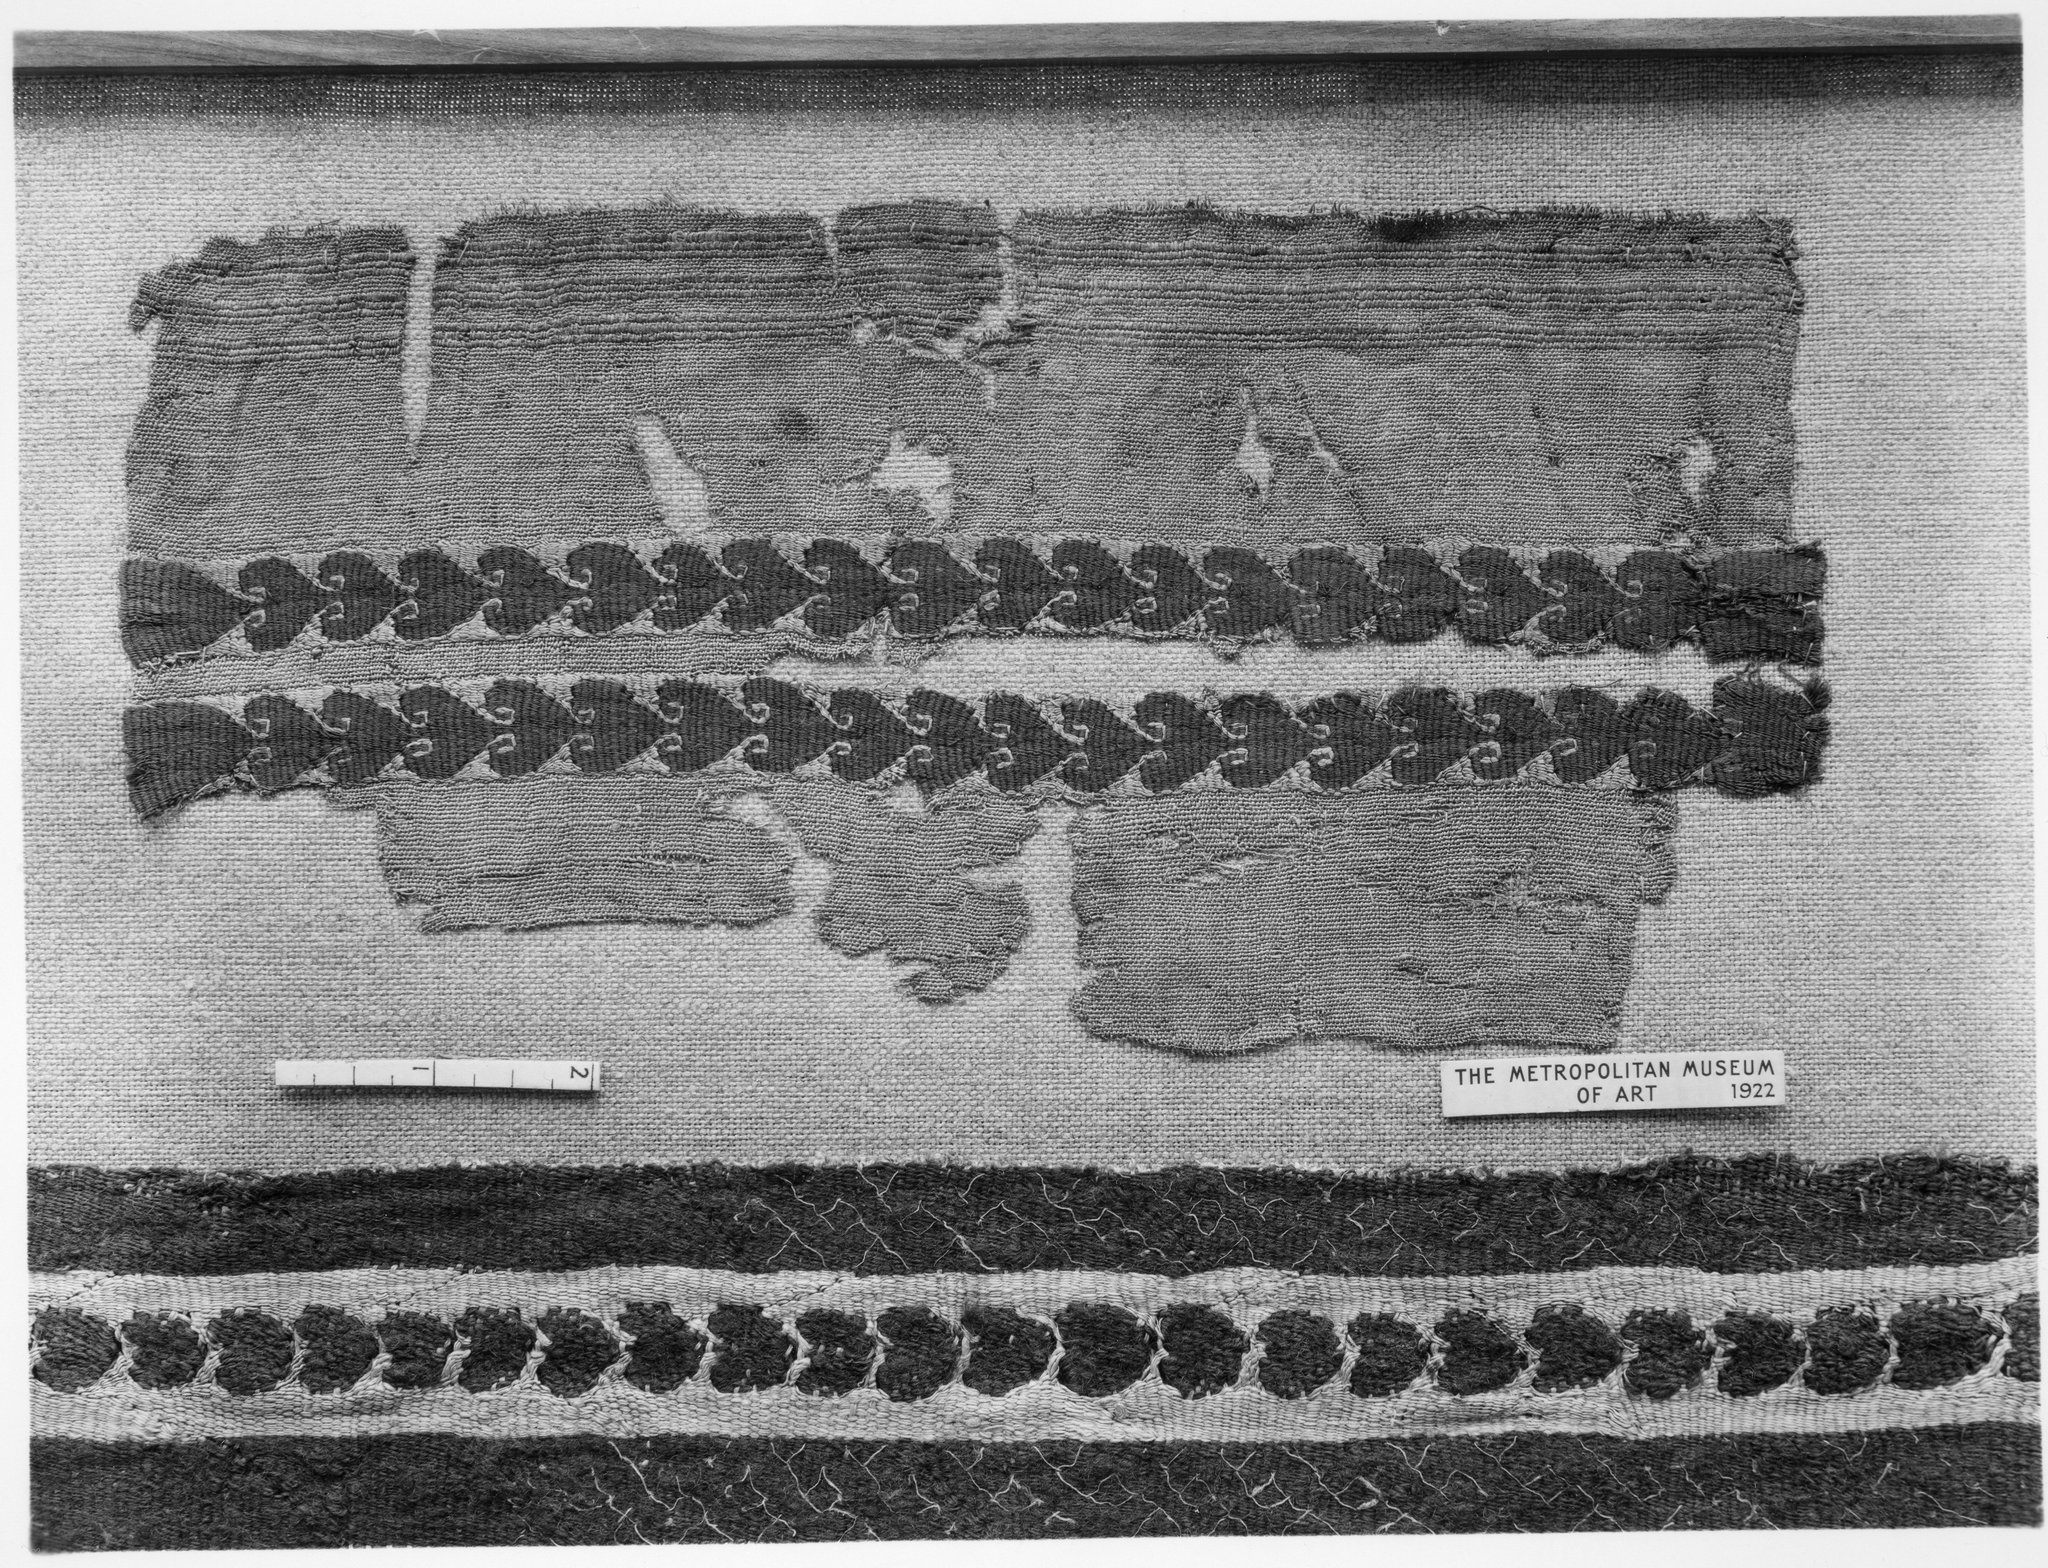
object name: textile fragment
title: Fragment of a Sleeve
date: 201-400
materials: linen, wool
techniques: weave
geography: egypt